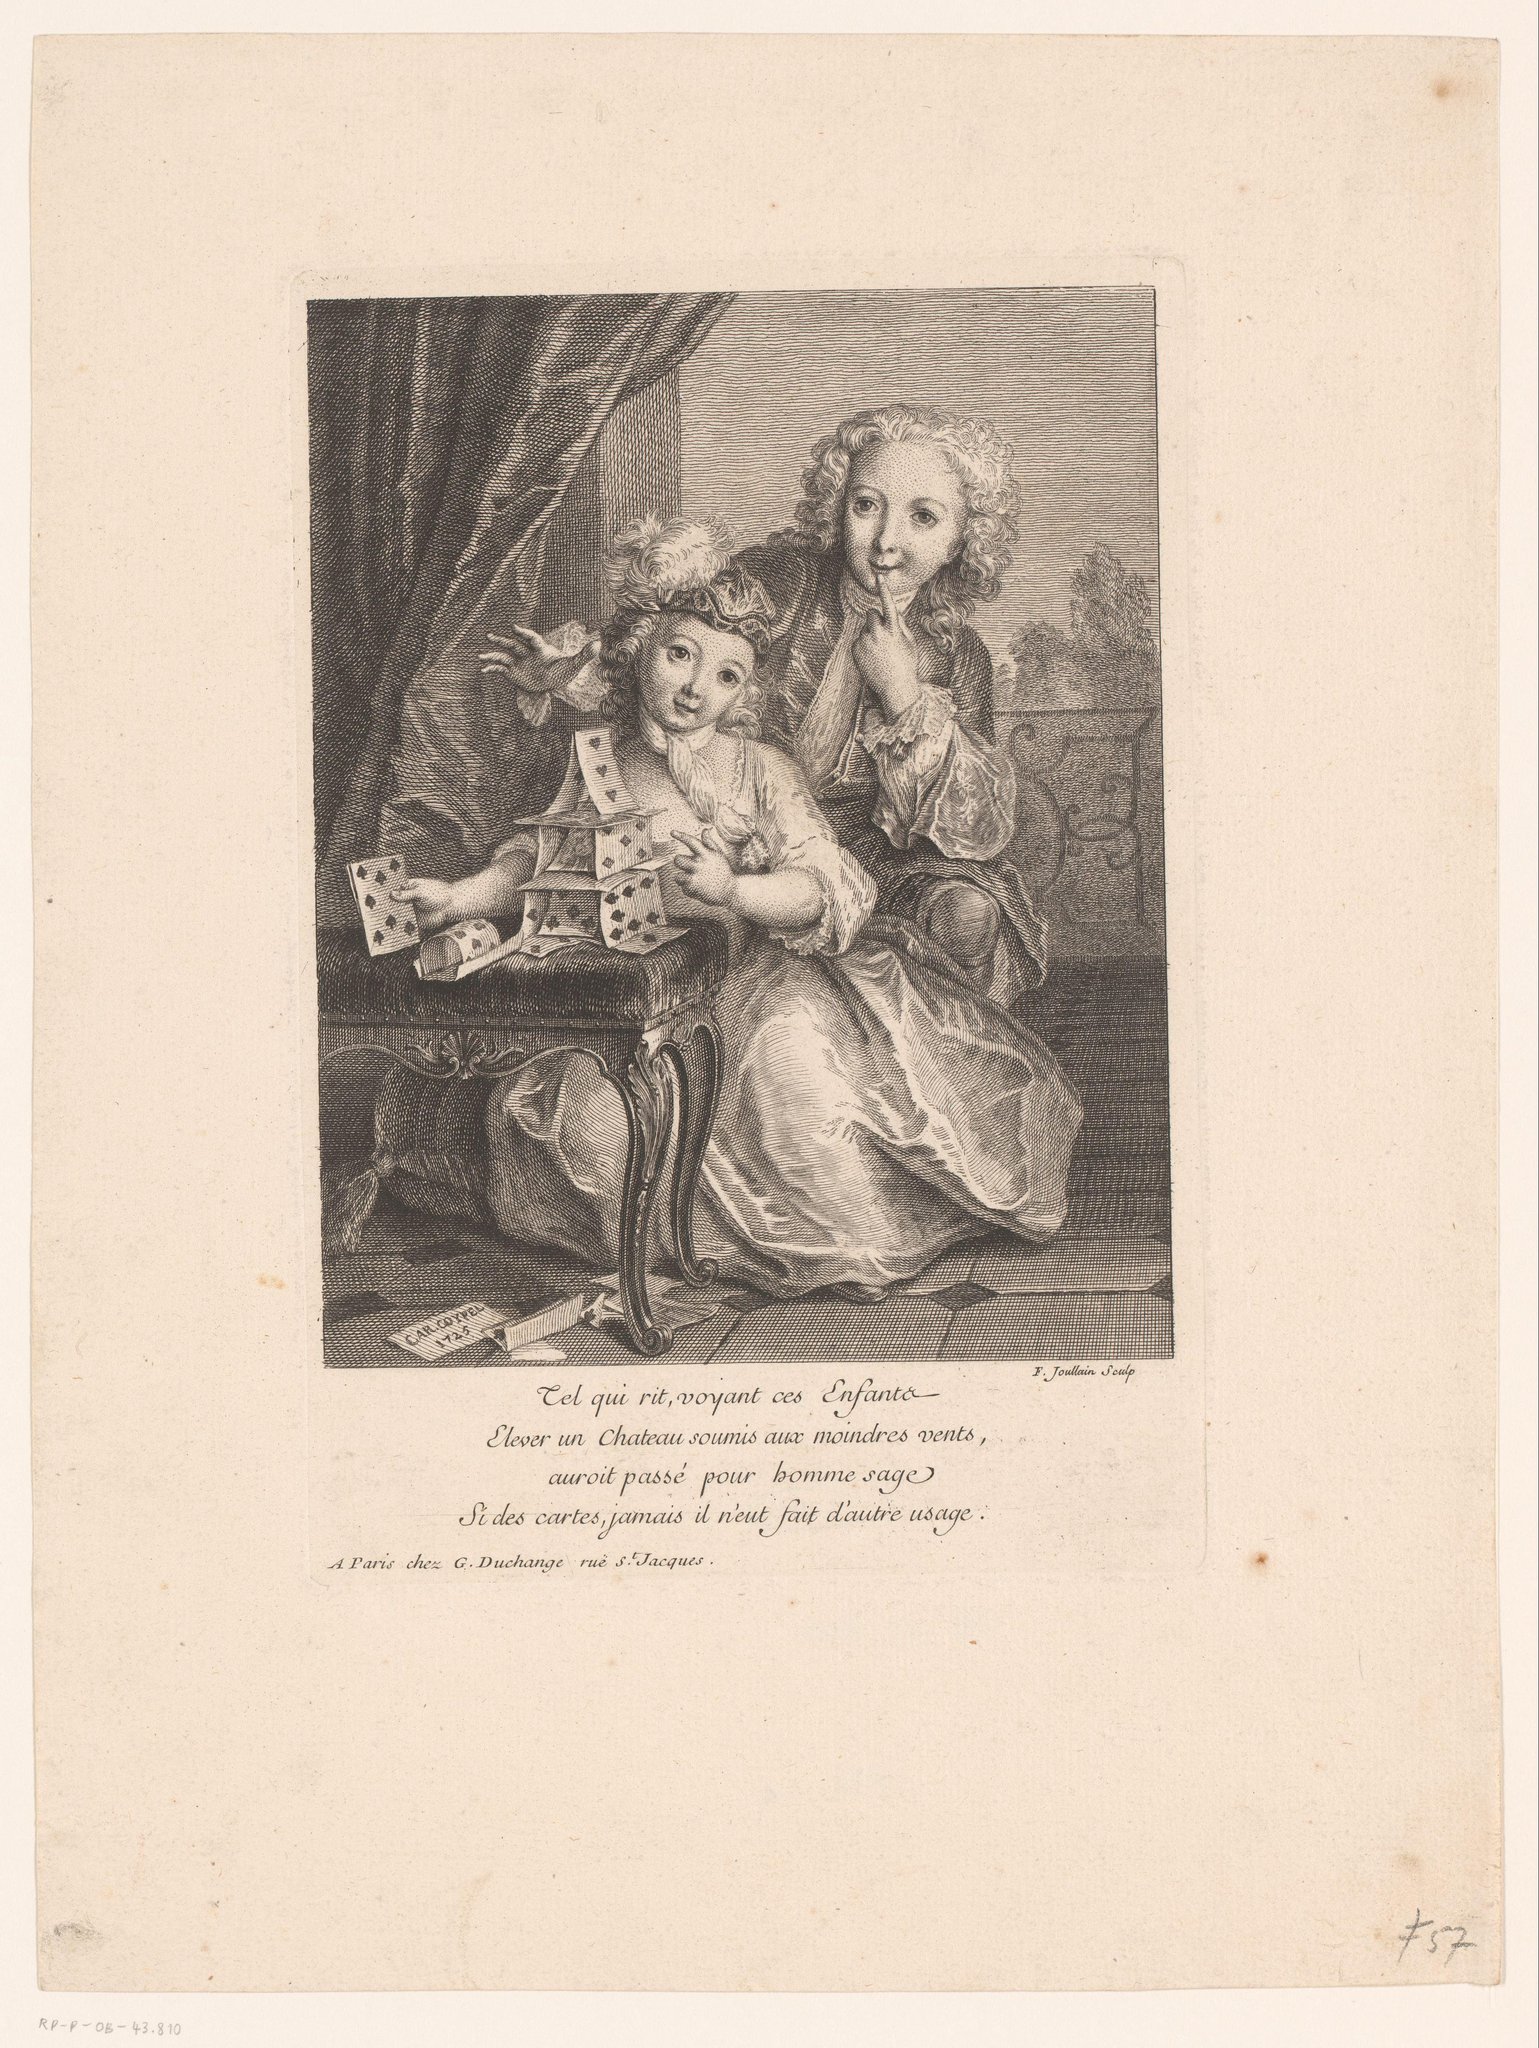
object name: print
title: Les Châteaux de cartes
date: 1725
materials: paper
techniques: engraving, etching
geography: france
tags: card games, child (at home)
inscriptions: collector's mark: Lugt 2228